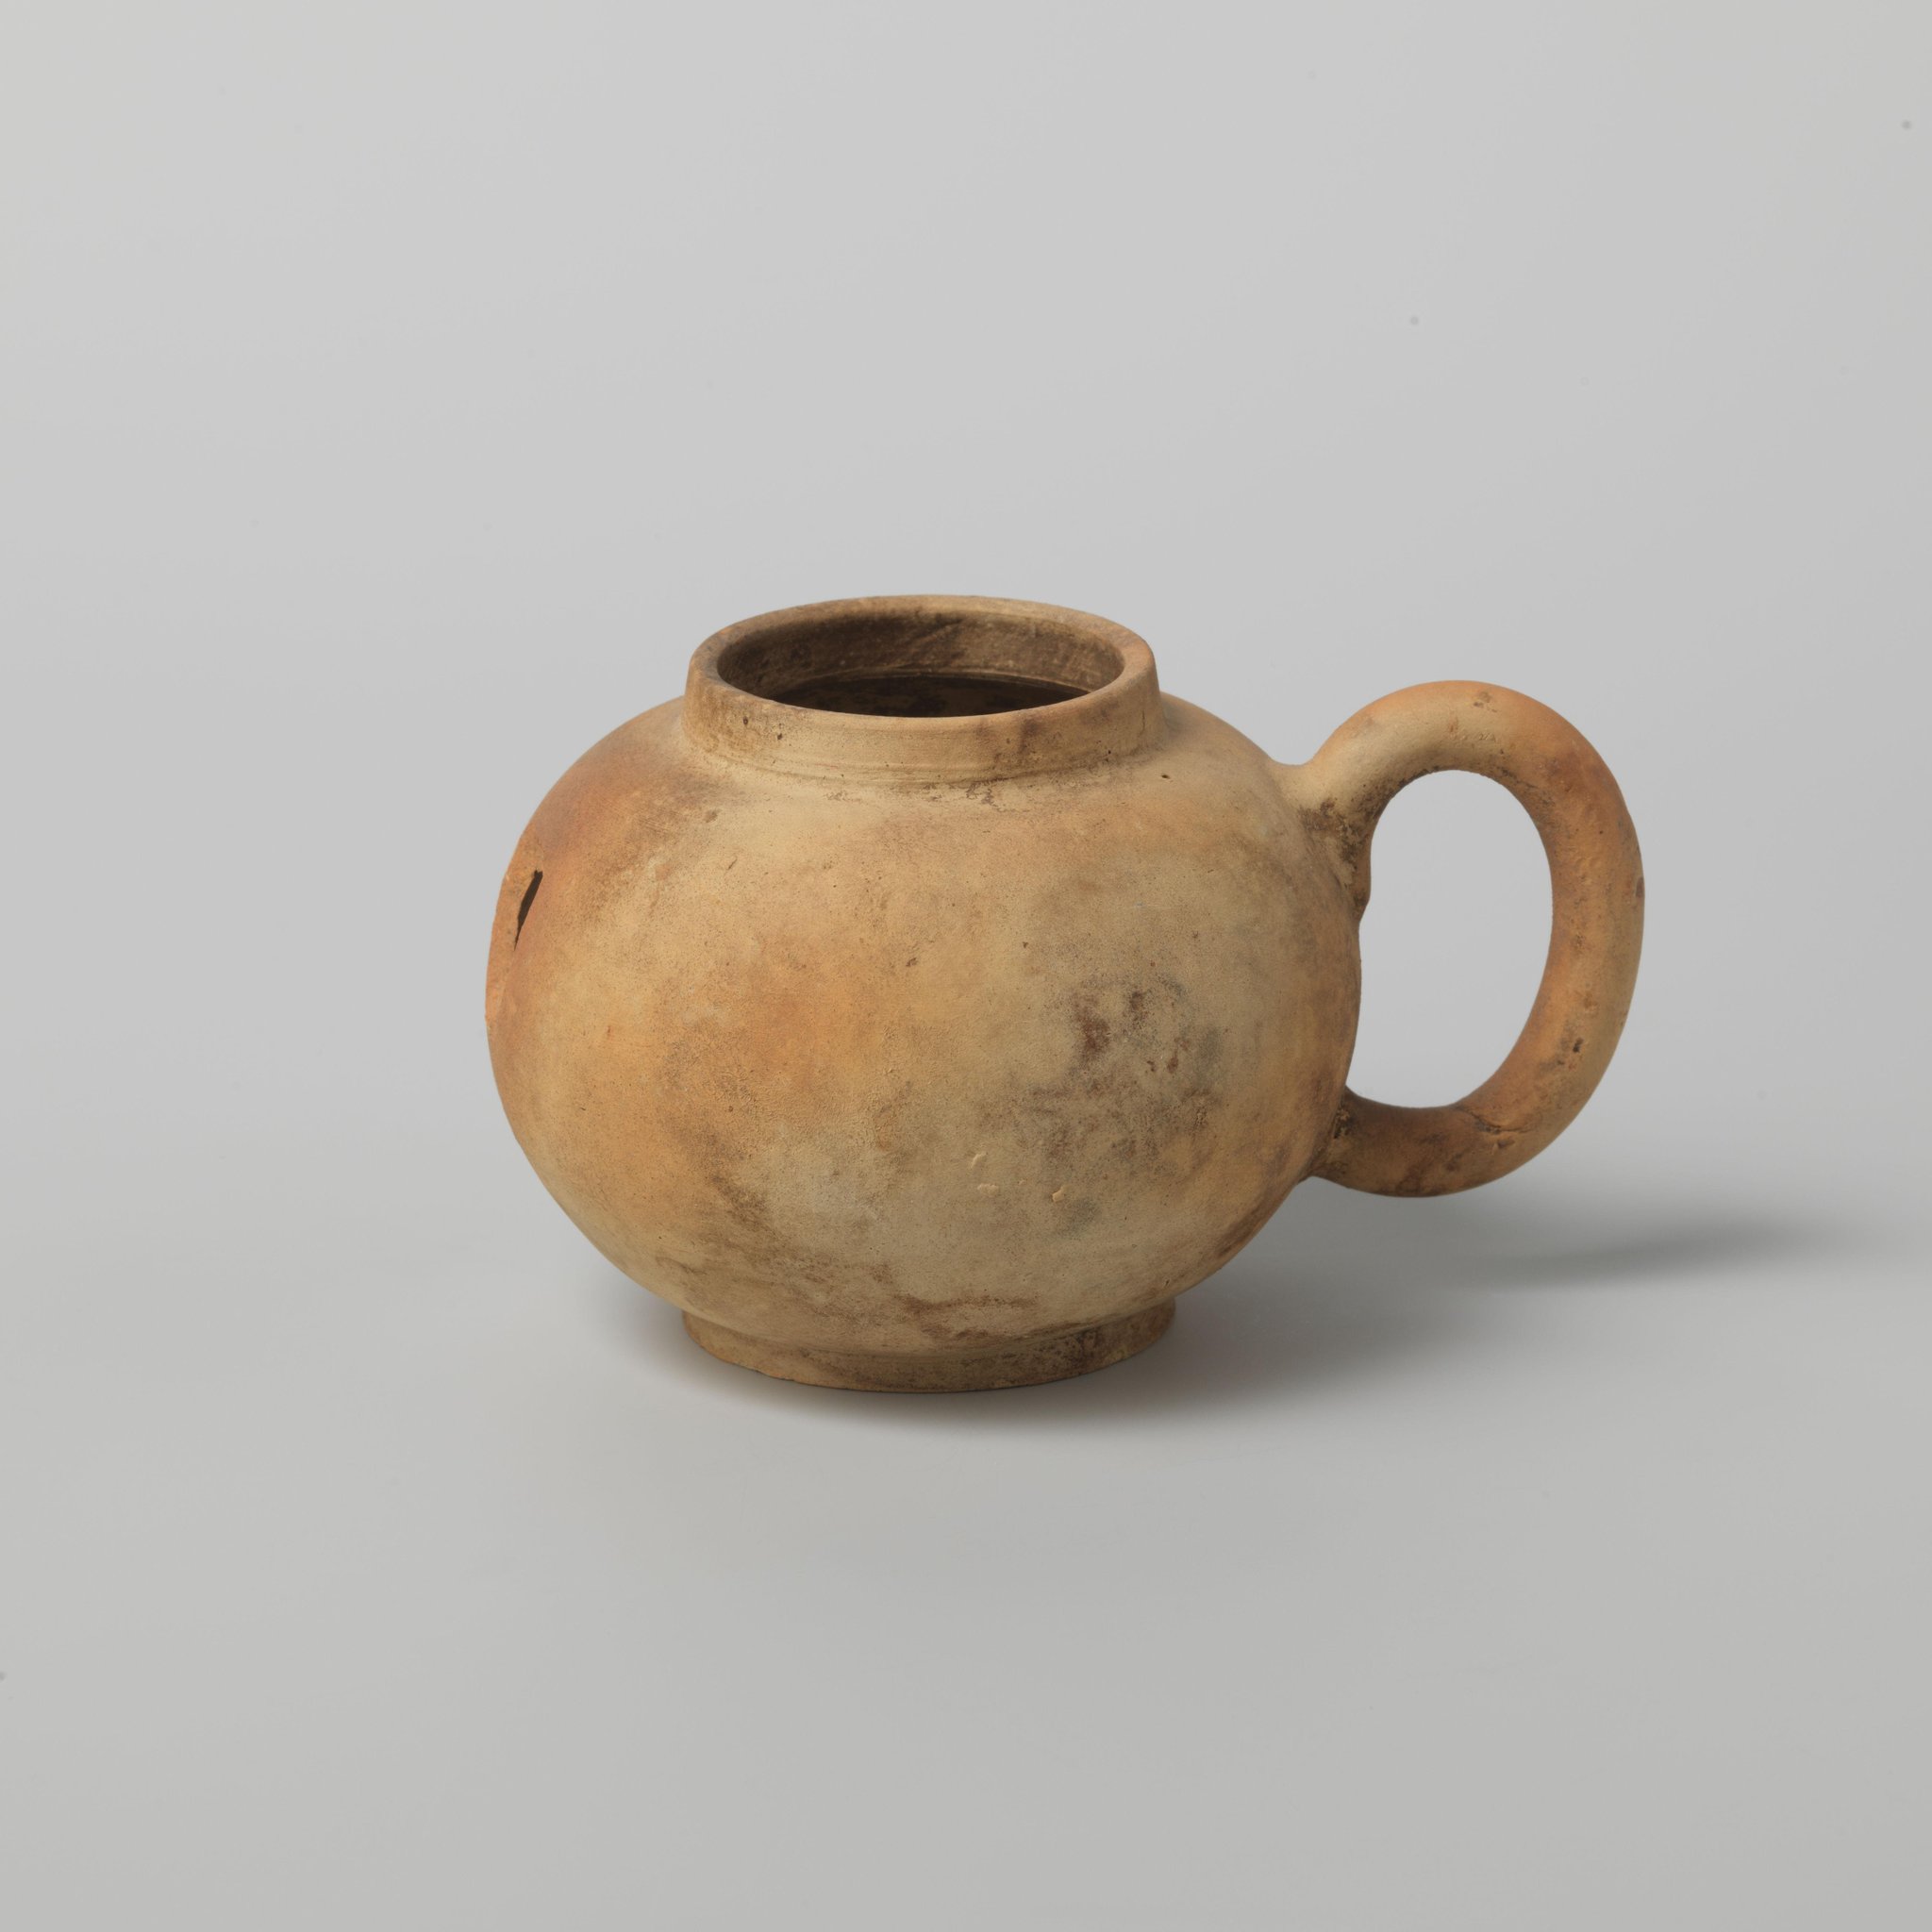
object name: teapot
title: Theepot van ongeglazuurd aardewerk (De Caluwe bakafval)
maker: jacobus de caluwe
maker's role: plateelbakkerij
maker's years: -1730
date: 1700-1725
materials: earthenware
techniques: firing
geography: delft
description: Toegeschreven aan Jacobus de Caluwe, omdat dit voorwerp samen met gemerkte stukken (‘Jacobus De Caluwe’ en rennend hert) gevonden is op de plaats waar zich De Caluwes tweede werkplaats bevond. Er is een duidelijke stilistische overeenkomst tussen de gemerkte en niet gemerkte voorwerpen uit deze archeologische vondst.